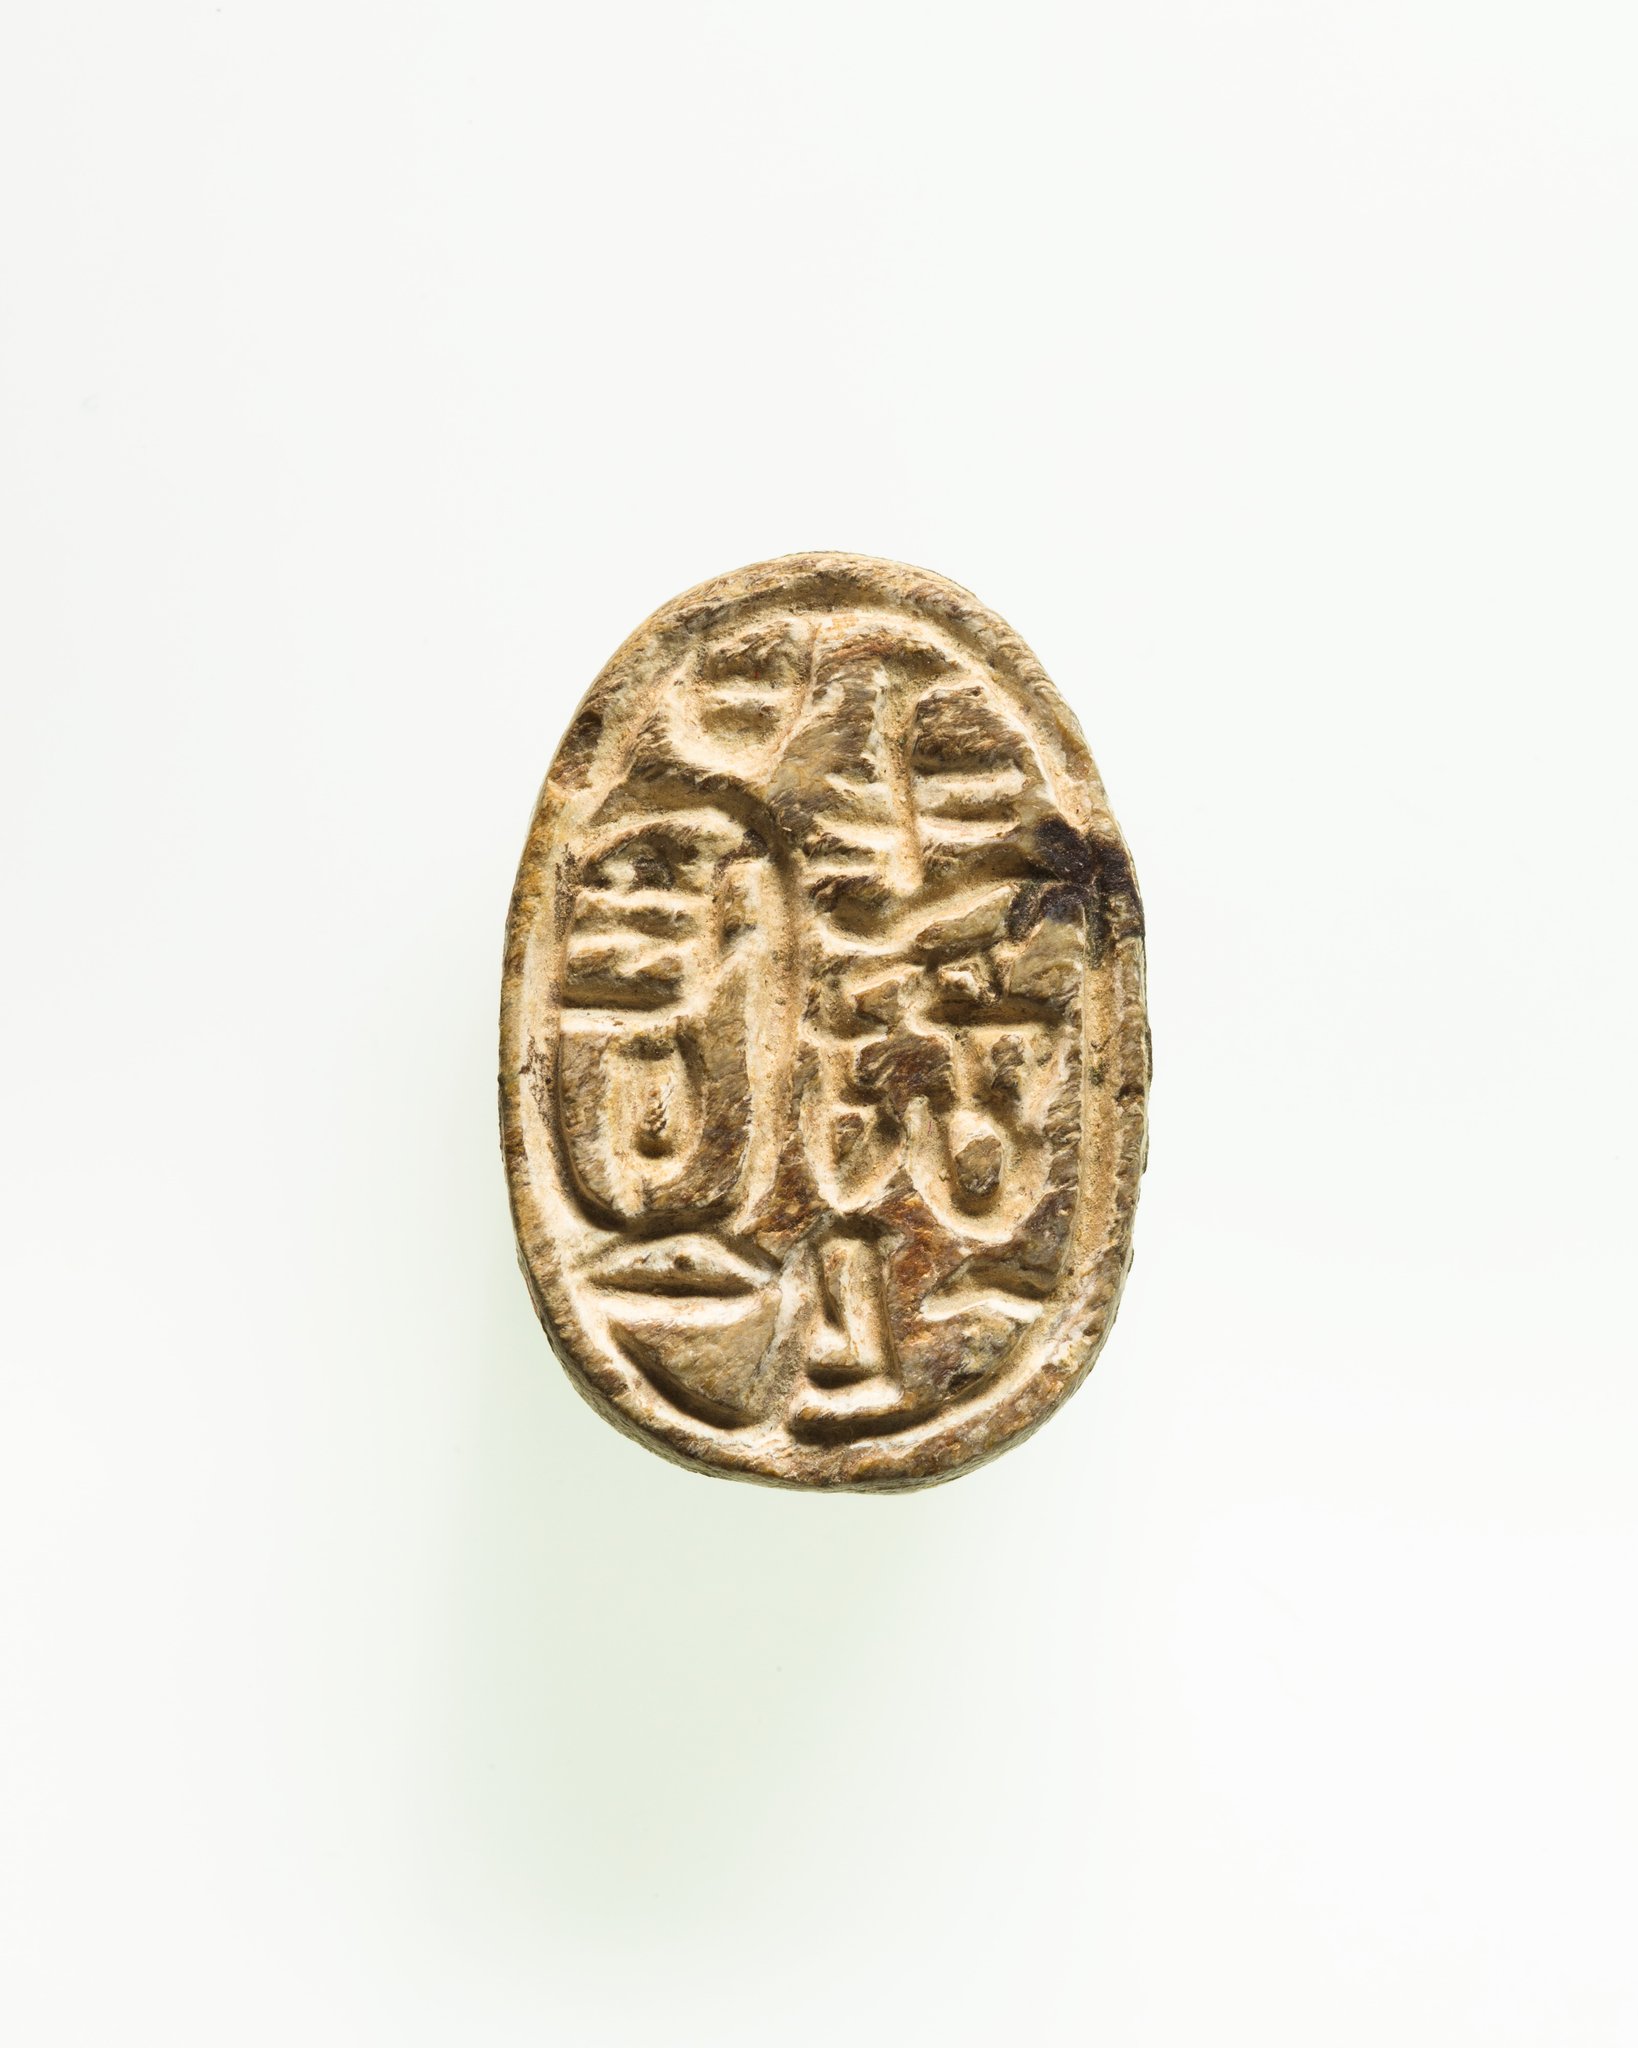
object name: scarab, queen inni, cartouche, royal title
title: Scarab of Queen Inni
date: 1700-1676 BCE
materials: faience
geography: egypt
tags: hieroglyphs,scarabs